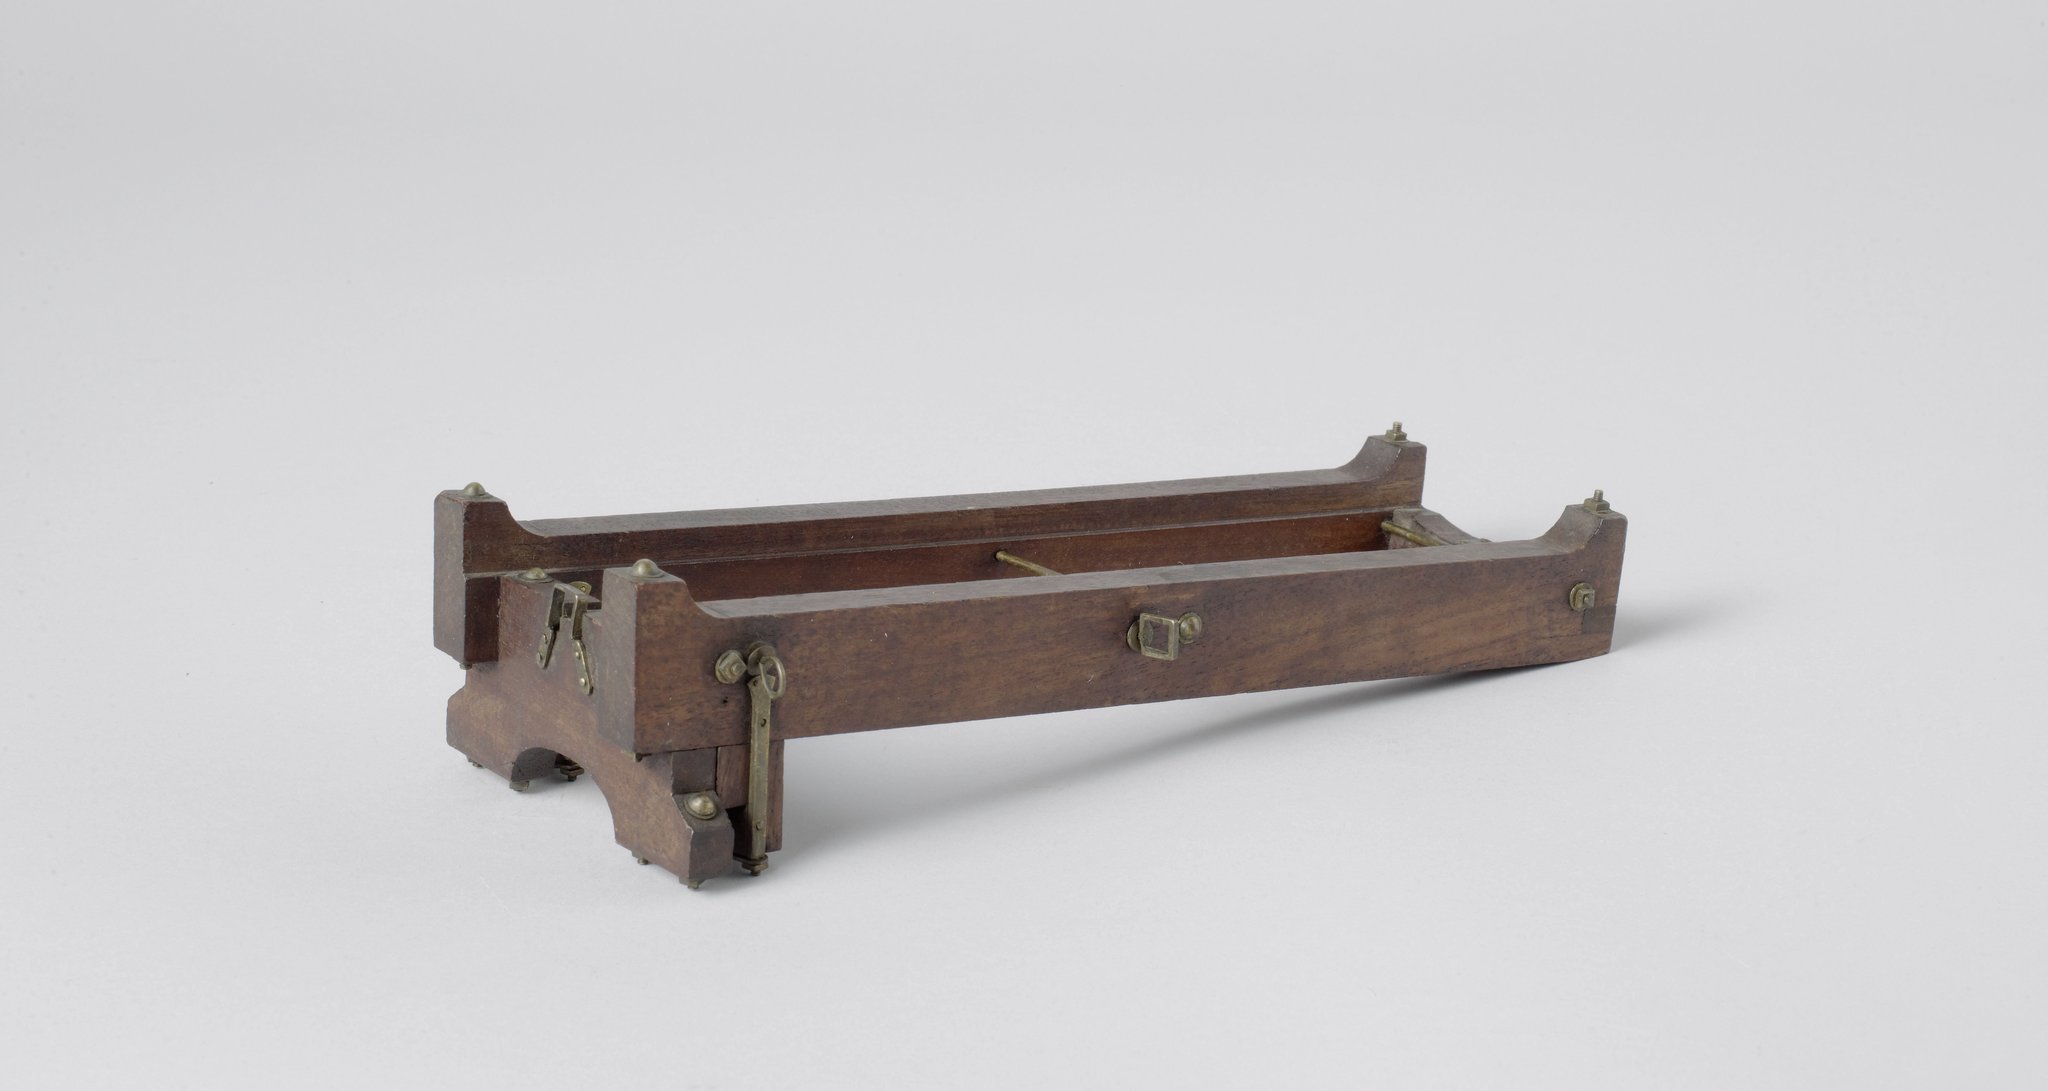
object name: demonstration model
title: Model of a Slide for a Gun Carriage of a Coastal Battery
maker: Anonymous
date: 1800-1850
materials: brass, wood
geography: netherlands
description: Model van de onderslede van een kanon van een kustbatterij, incompleet. Het bestaat uit een rechthoekig frame met messing beslag; de balken in langsrichting hebben omhoogkomende uiteinden. Op de dwarsbalk achter is het beslag voor het baksijzer aangebracht. Voor het baksen heeft de slede een gat voor een zwenkingsspil in de dwarsbalk voor, en beslag voor twee zwenkwielen in de verhoogde dwarsbalk achter: de assen van de wielen staan radiaal ten opzichte van het zwenkingspunt.